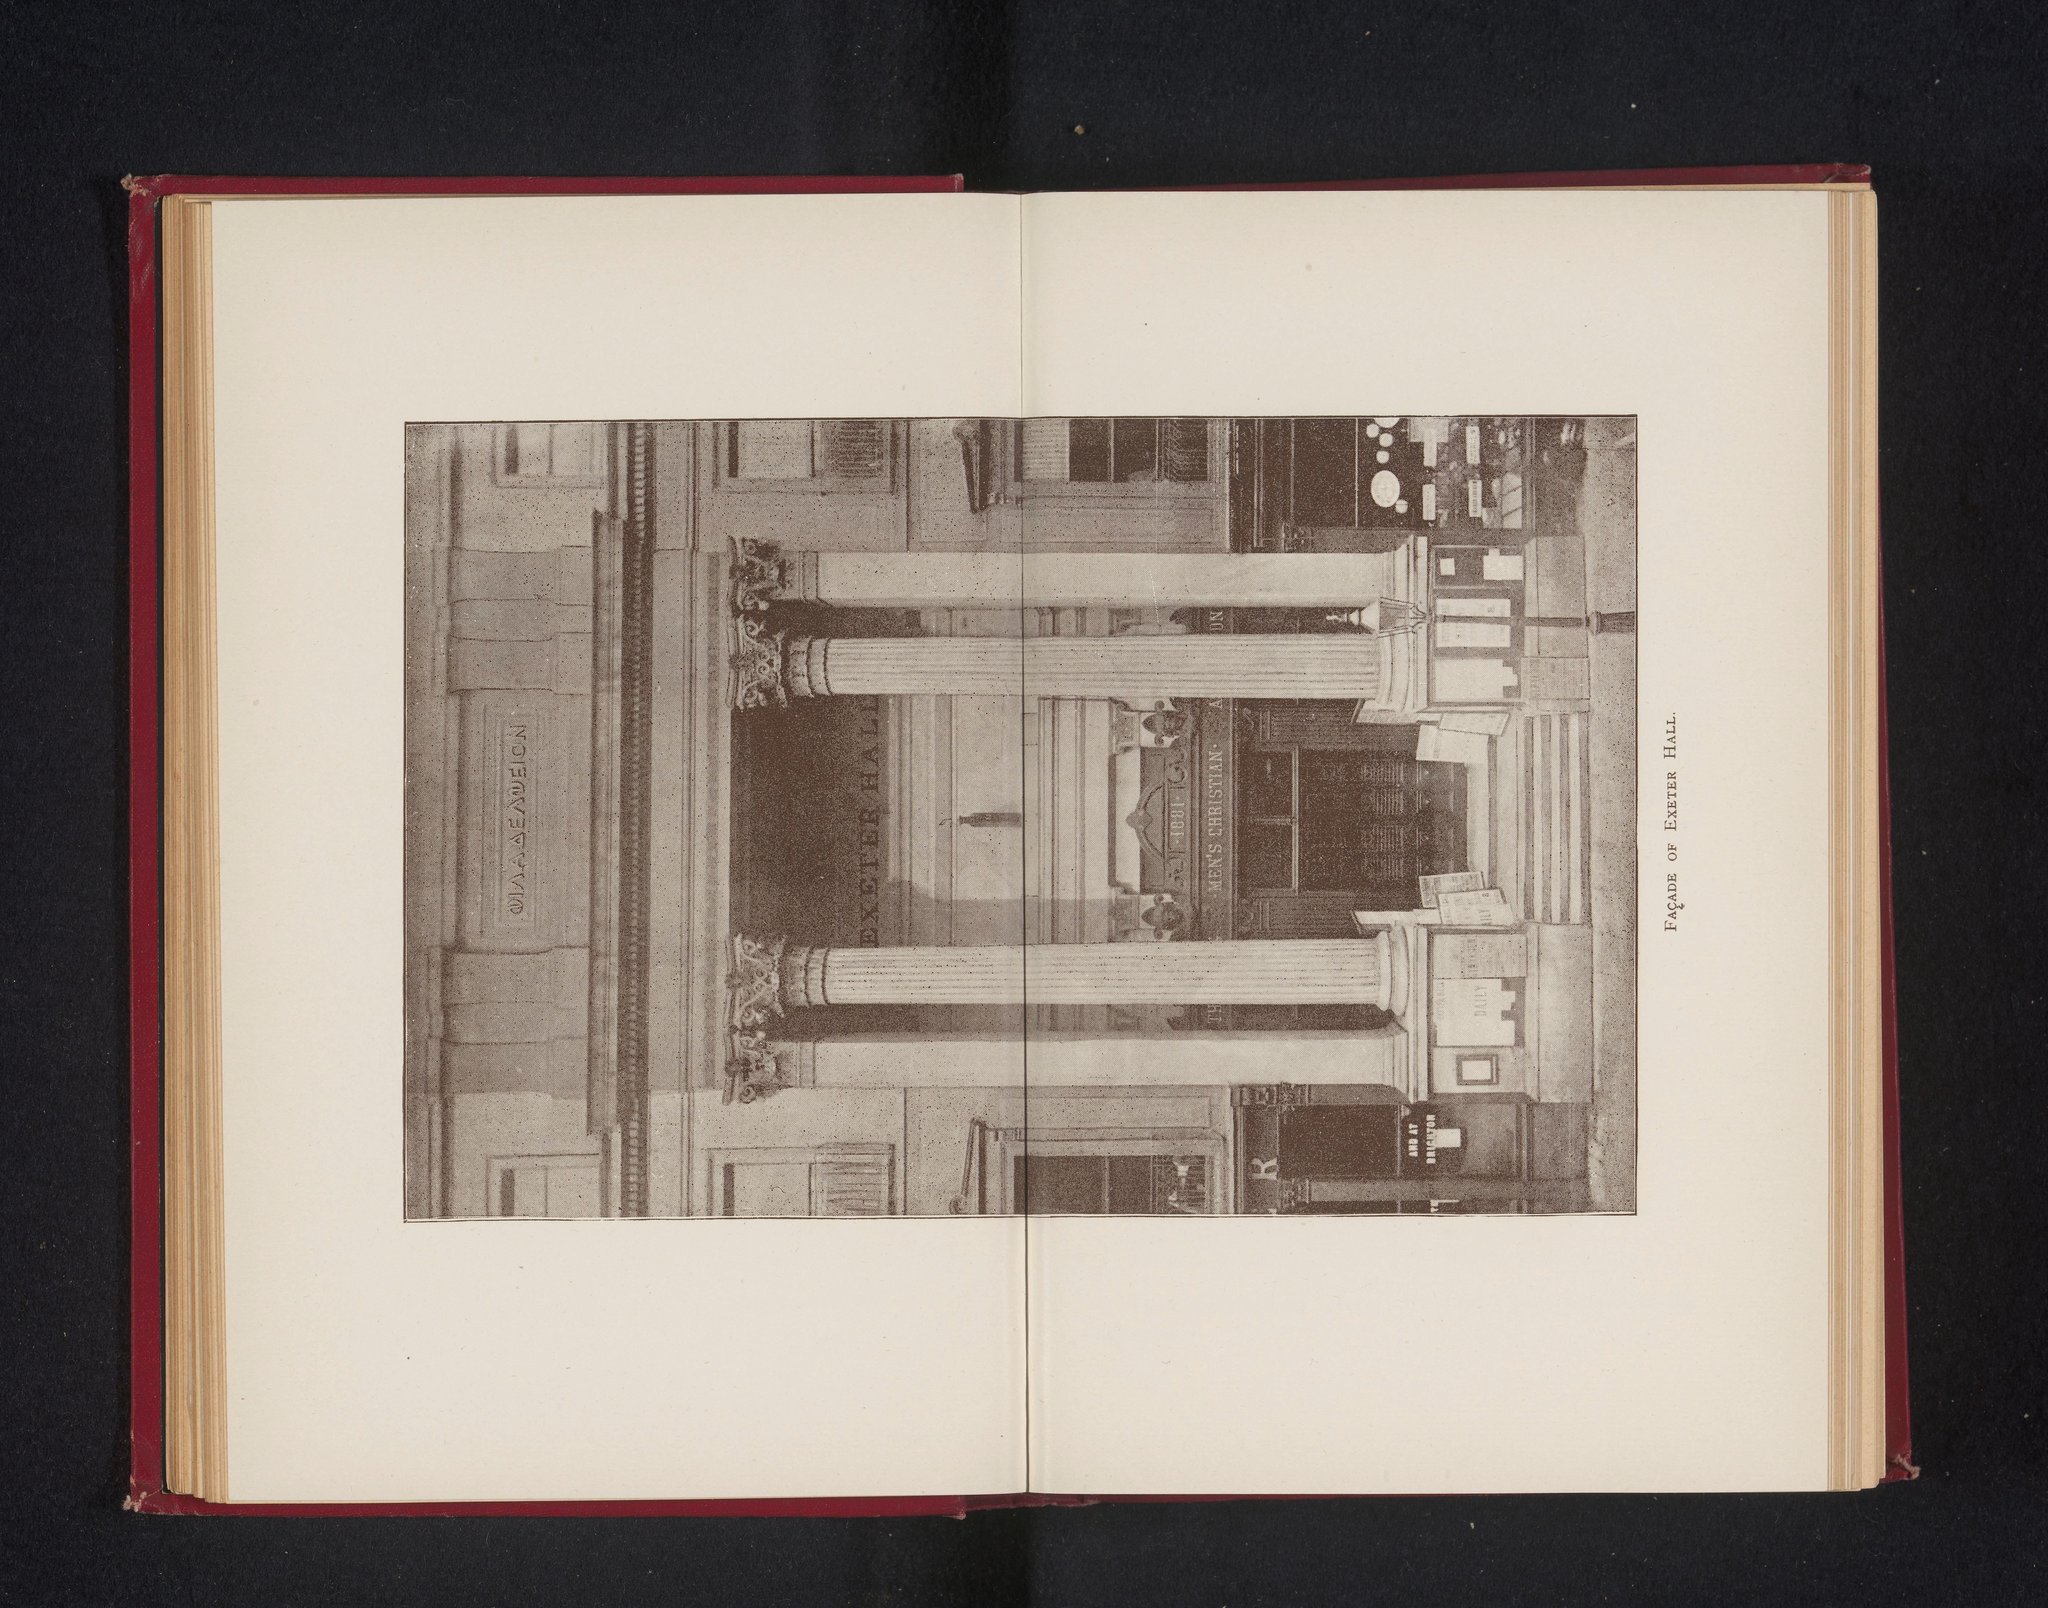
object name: page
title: Gezicht op de façade van Exeter Hall in Londen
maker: Anonymous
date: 1890-1895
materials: paper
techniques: autotype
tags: façade (of house or building), edifice, e.g.: public building, department store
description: Prent op vierde en vijfde ongenummerde pagina na pagina 18.